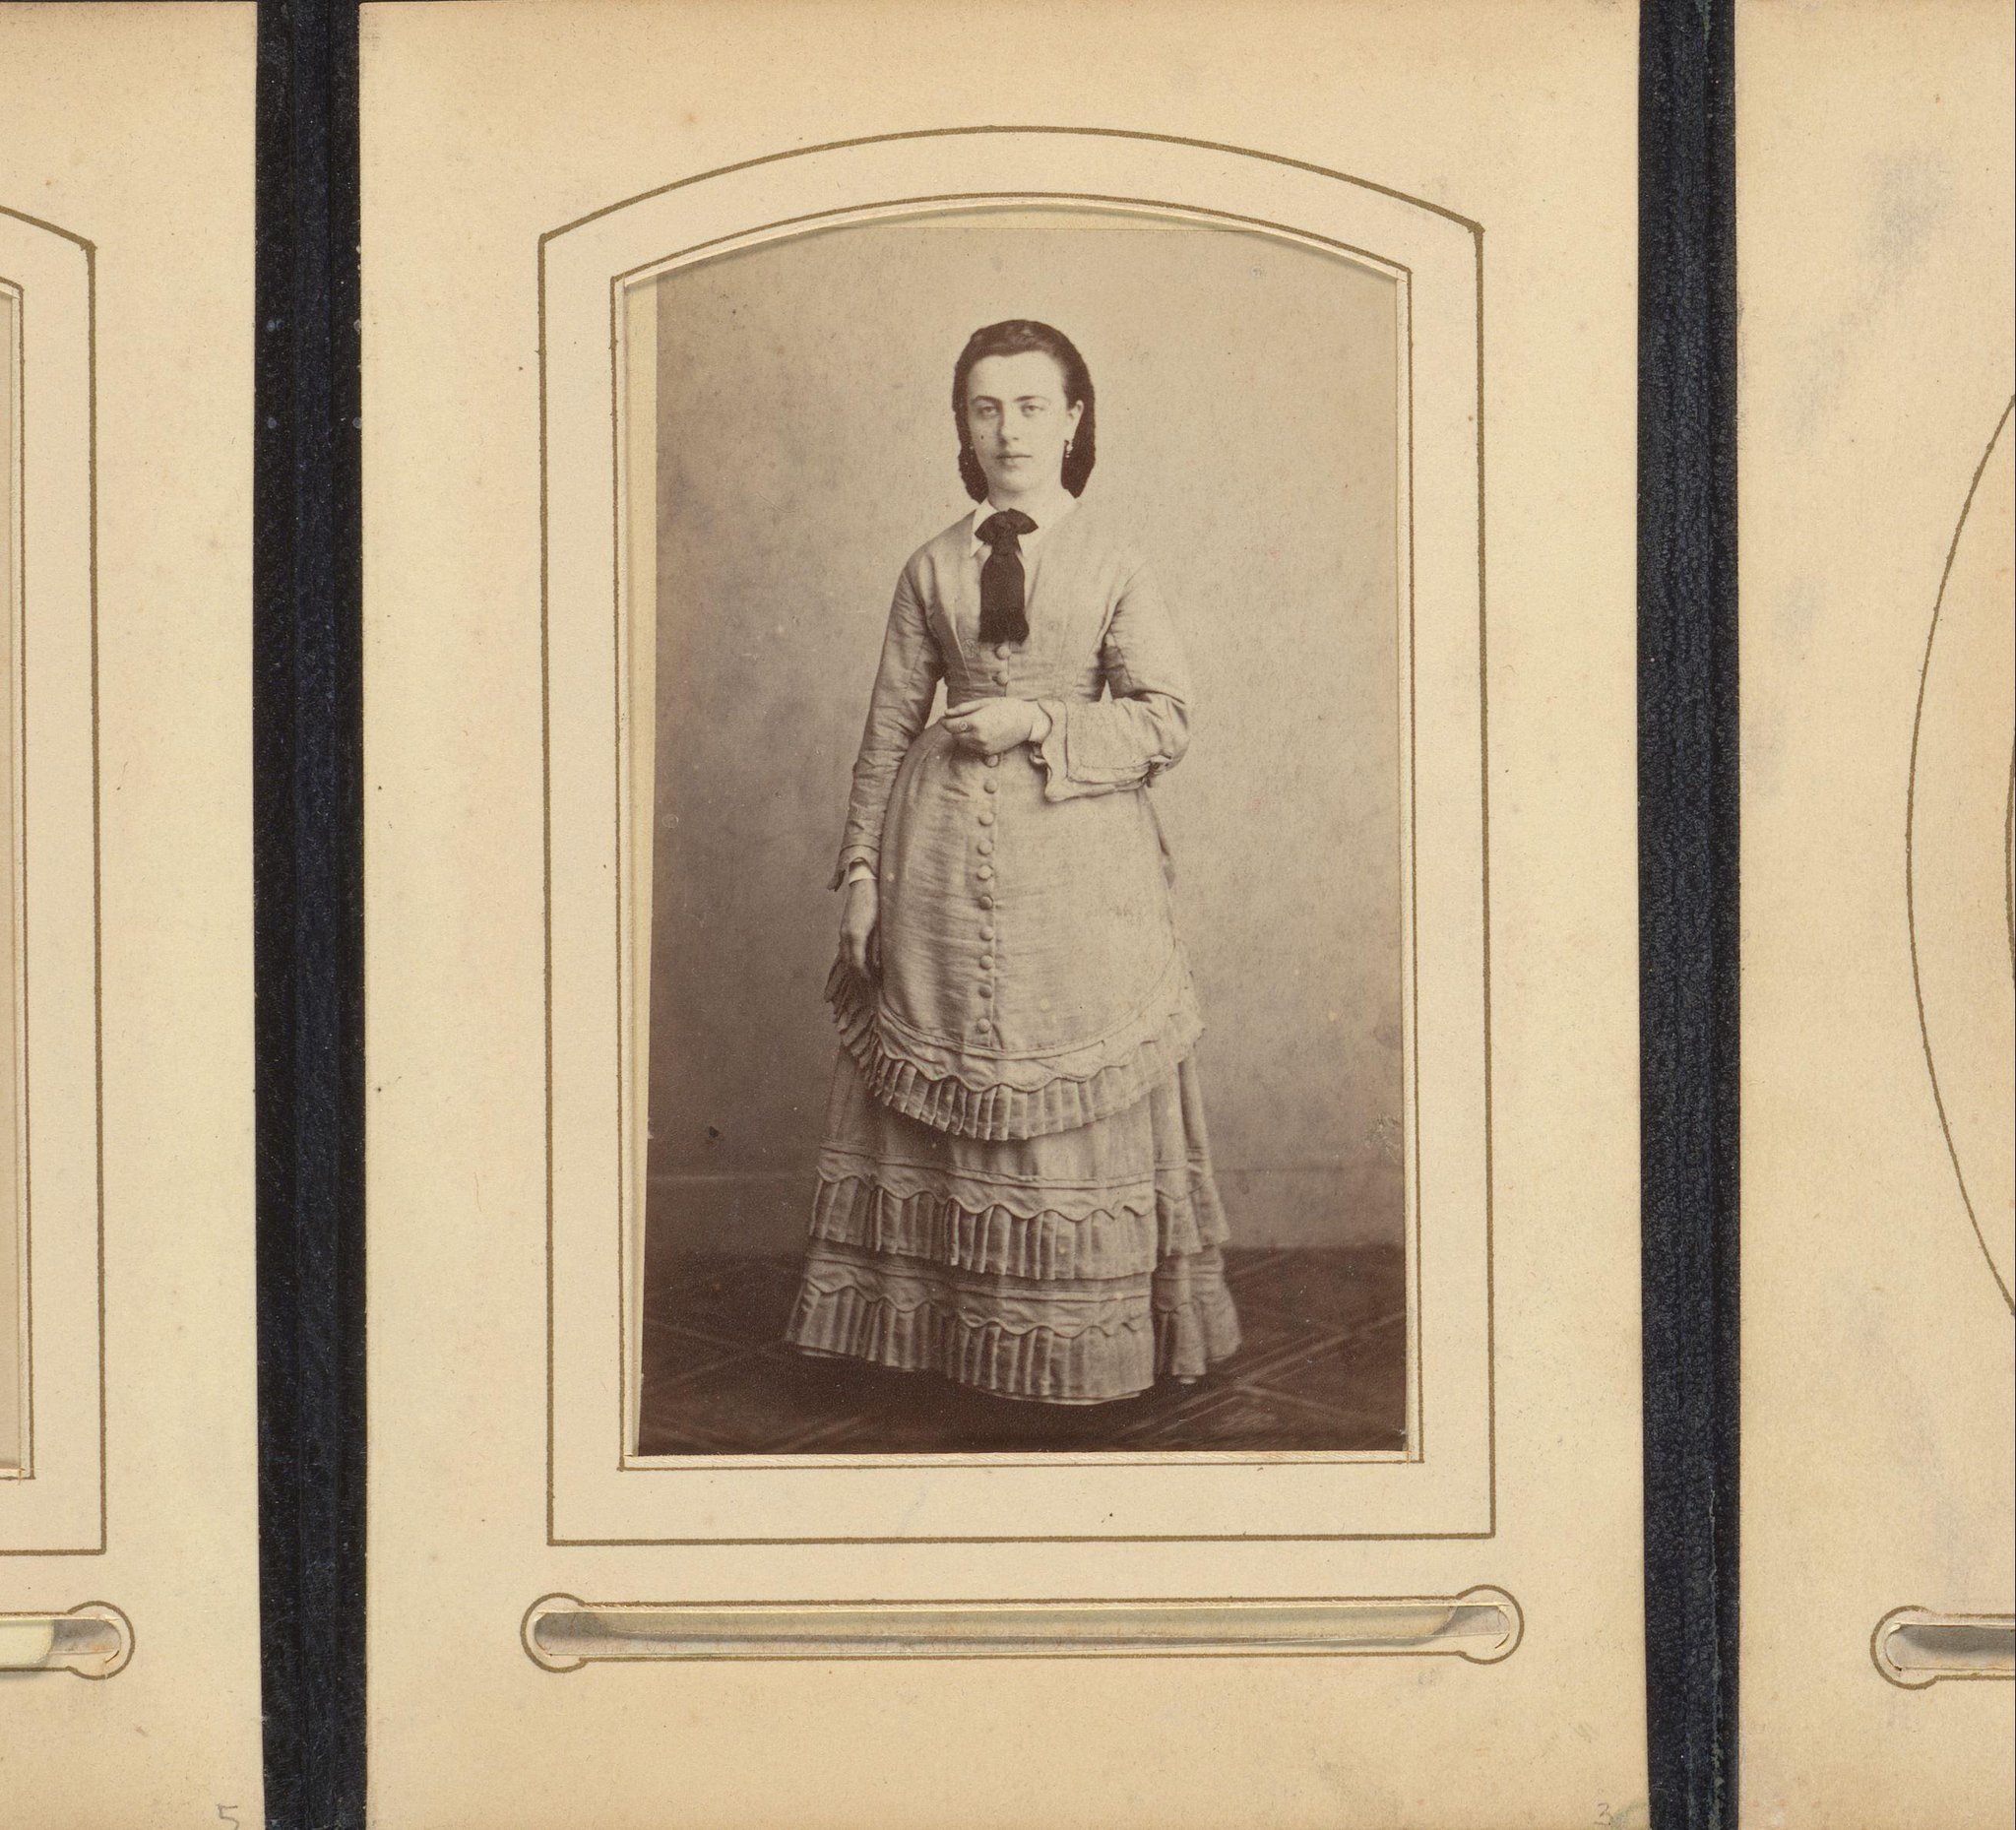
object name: carte de visite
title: Portret van een staande vrouw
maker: antonius godefridus schull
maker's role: fotograaf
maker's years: 1819-1896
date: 1860-1885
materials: cardboard, photographic support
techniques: albumen print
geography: den bosch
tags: historical persons - bb - woman, standing figure - aa - female human figure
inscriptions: inscription: ‘(...)/ A. G. Schull/ PHOTOGRAPHE/ Kerkstraat/ 's HERTOGENBOSCH’